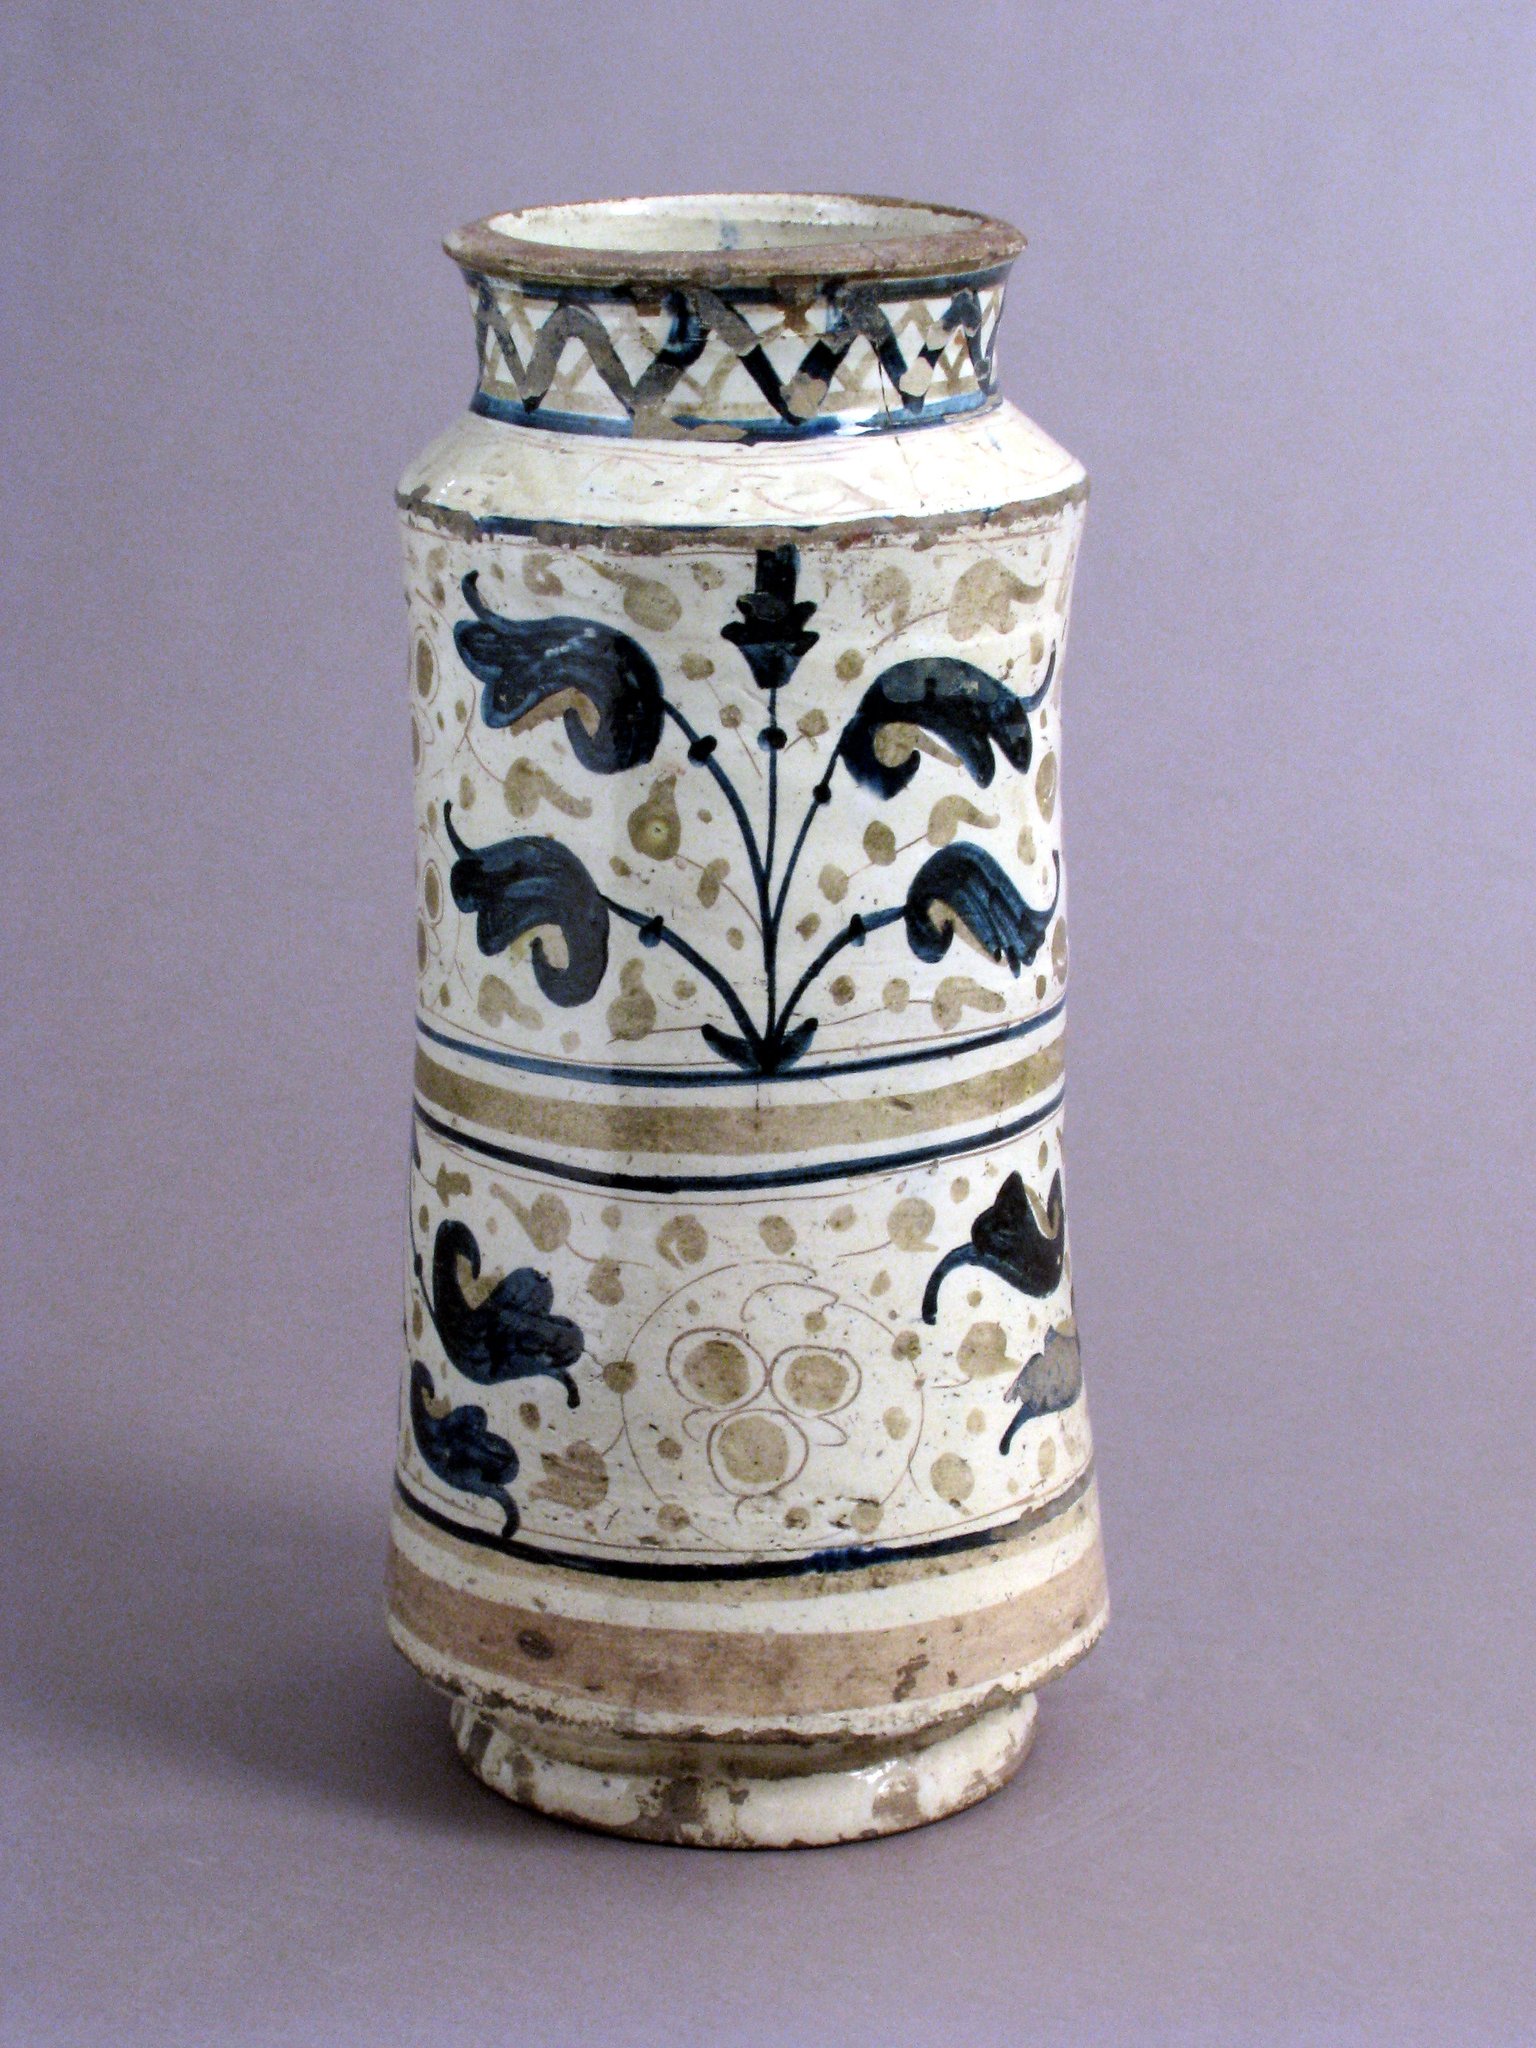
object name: pharmacy jar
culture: spanish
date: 1401-1500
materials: earthenware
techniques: glazing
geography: spain